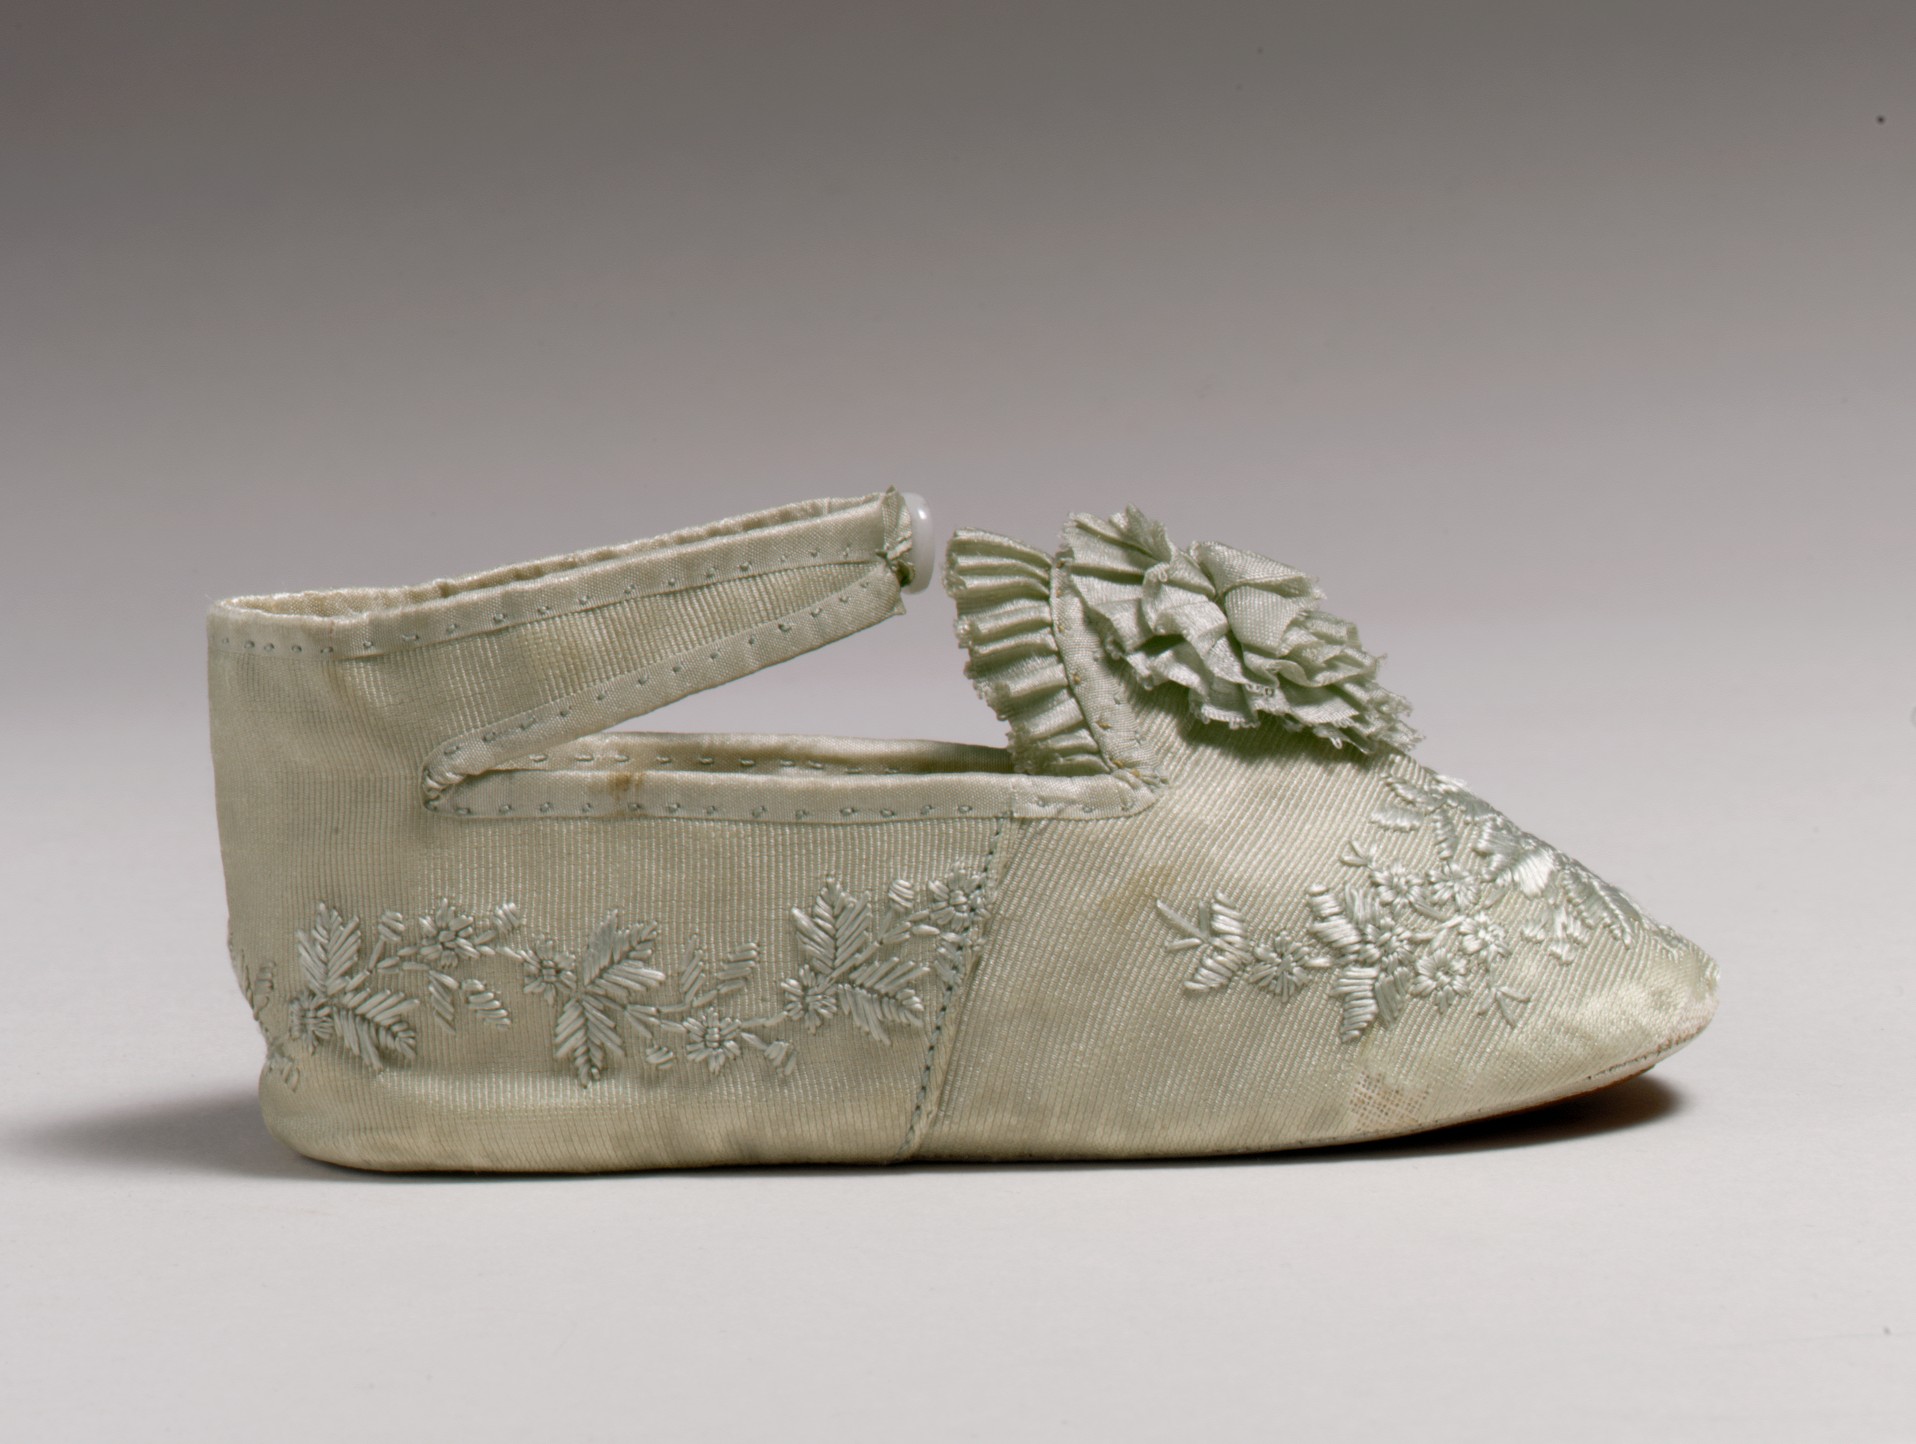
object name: shoe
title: Shoes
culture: american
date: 1834-1866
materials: cotton, leather, silk